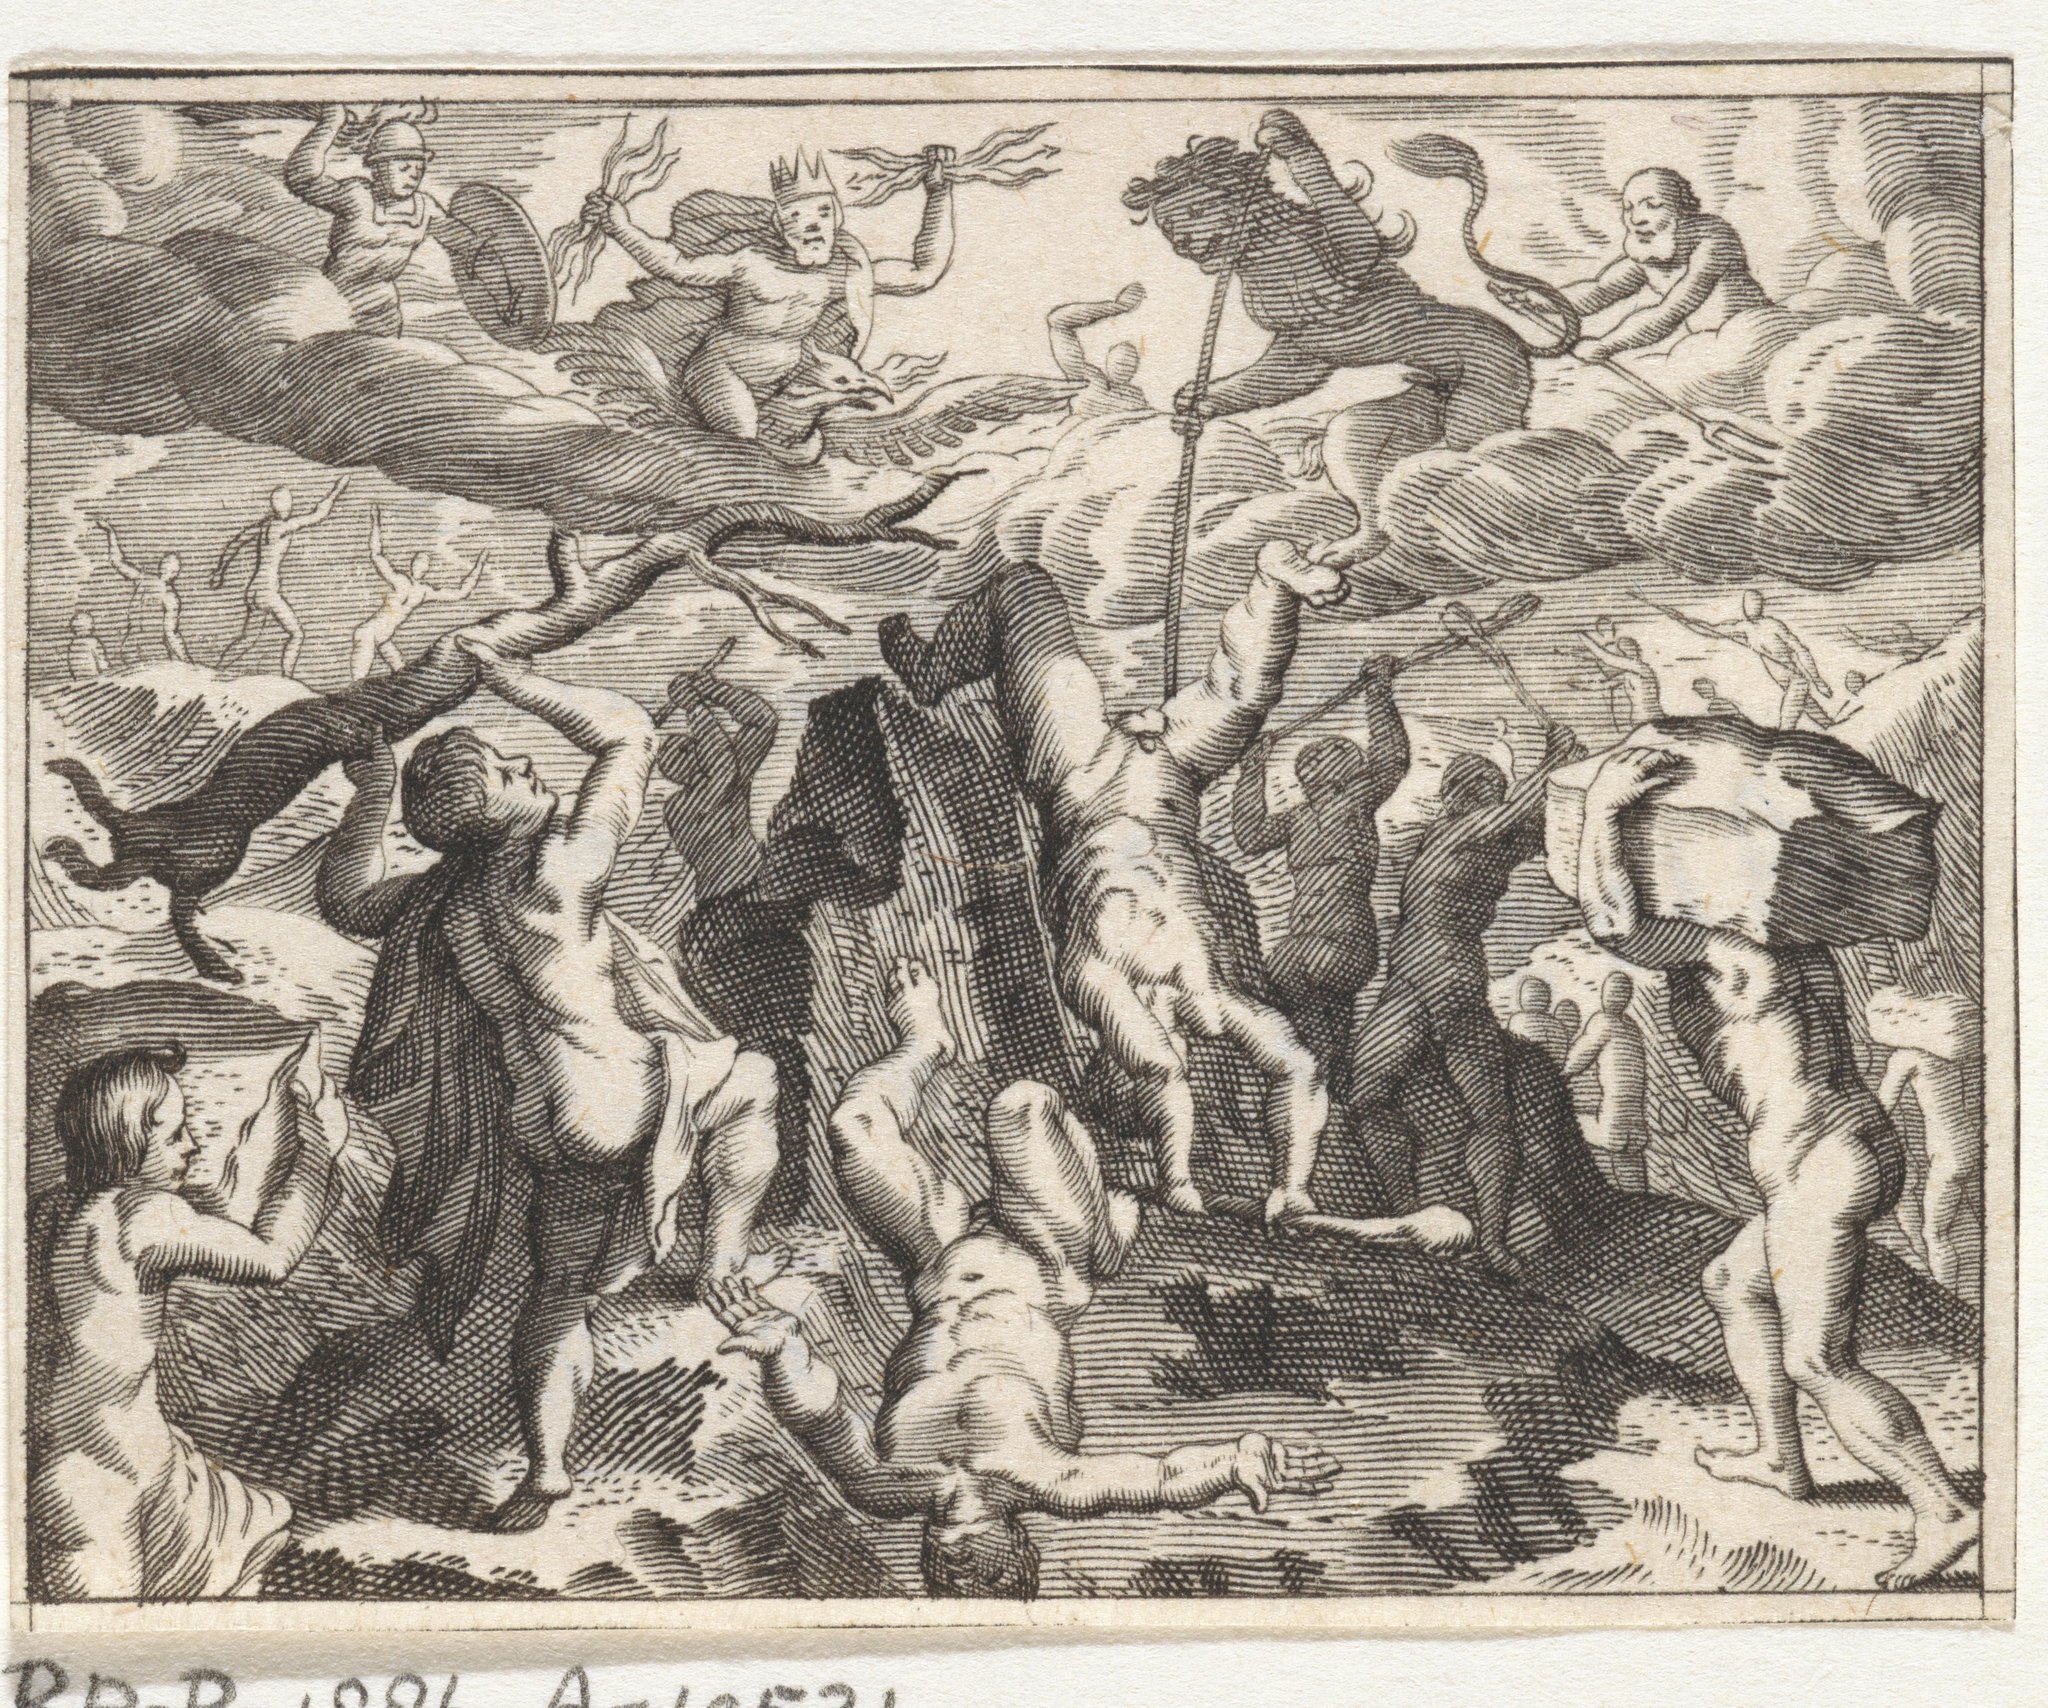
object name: print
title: Bacchus helpt de Titanen verslaan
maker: pieter serwouters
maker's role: draughtsman, print maker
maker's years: 1586-1657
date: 1616-1657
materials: paper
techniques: engraving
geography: amsterdam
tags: war of the titans against jupiter and allies: titanomachy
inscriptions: collector's mark: Lugt 2228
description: Bacchus helpt de goden in hun gevecht tegen de titanen.